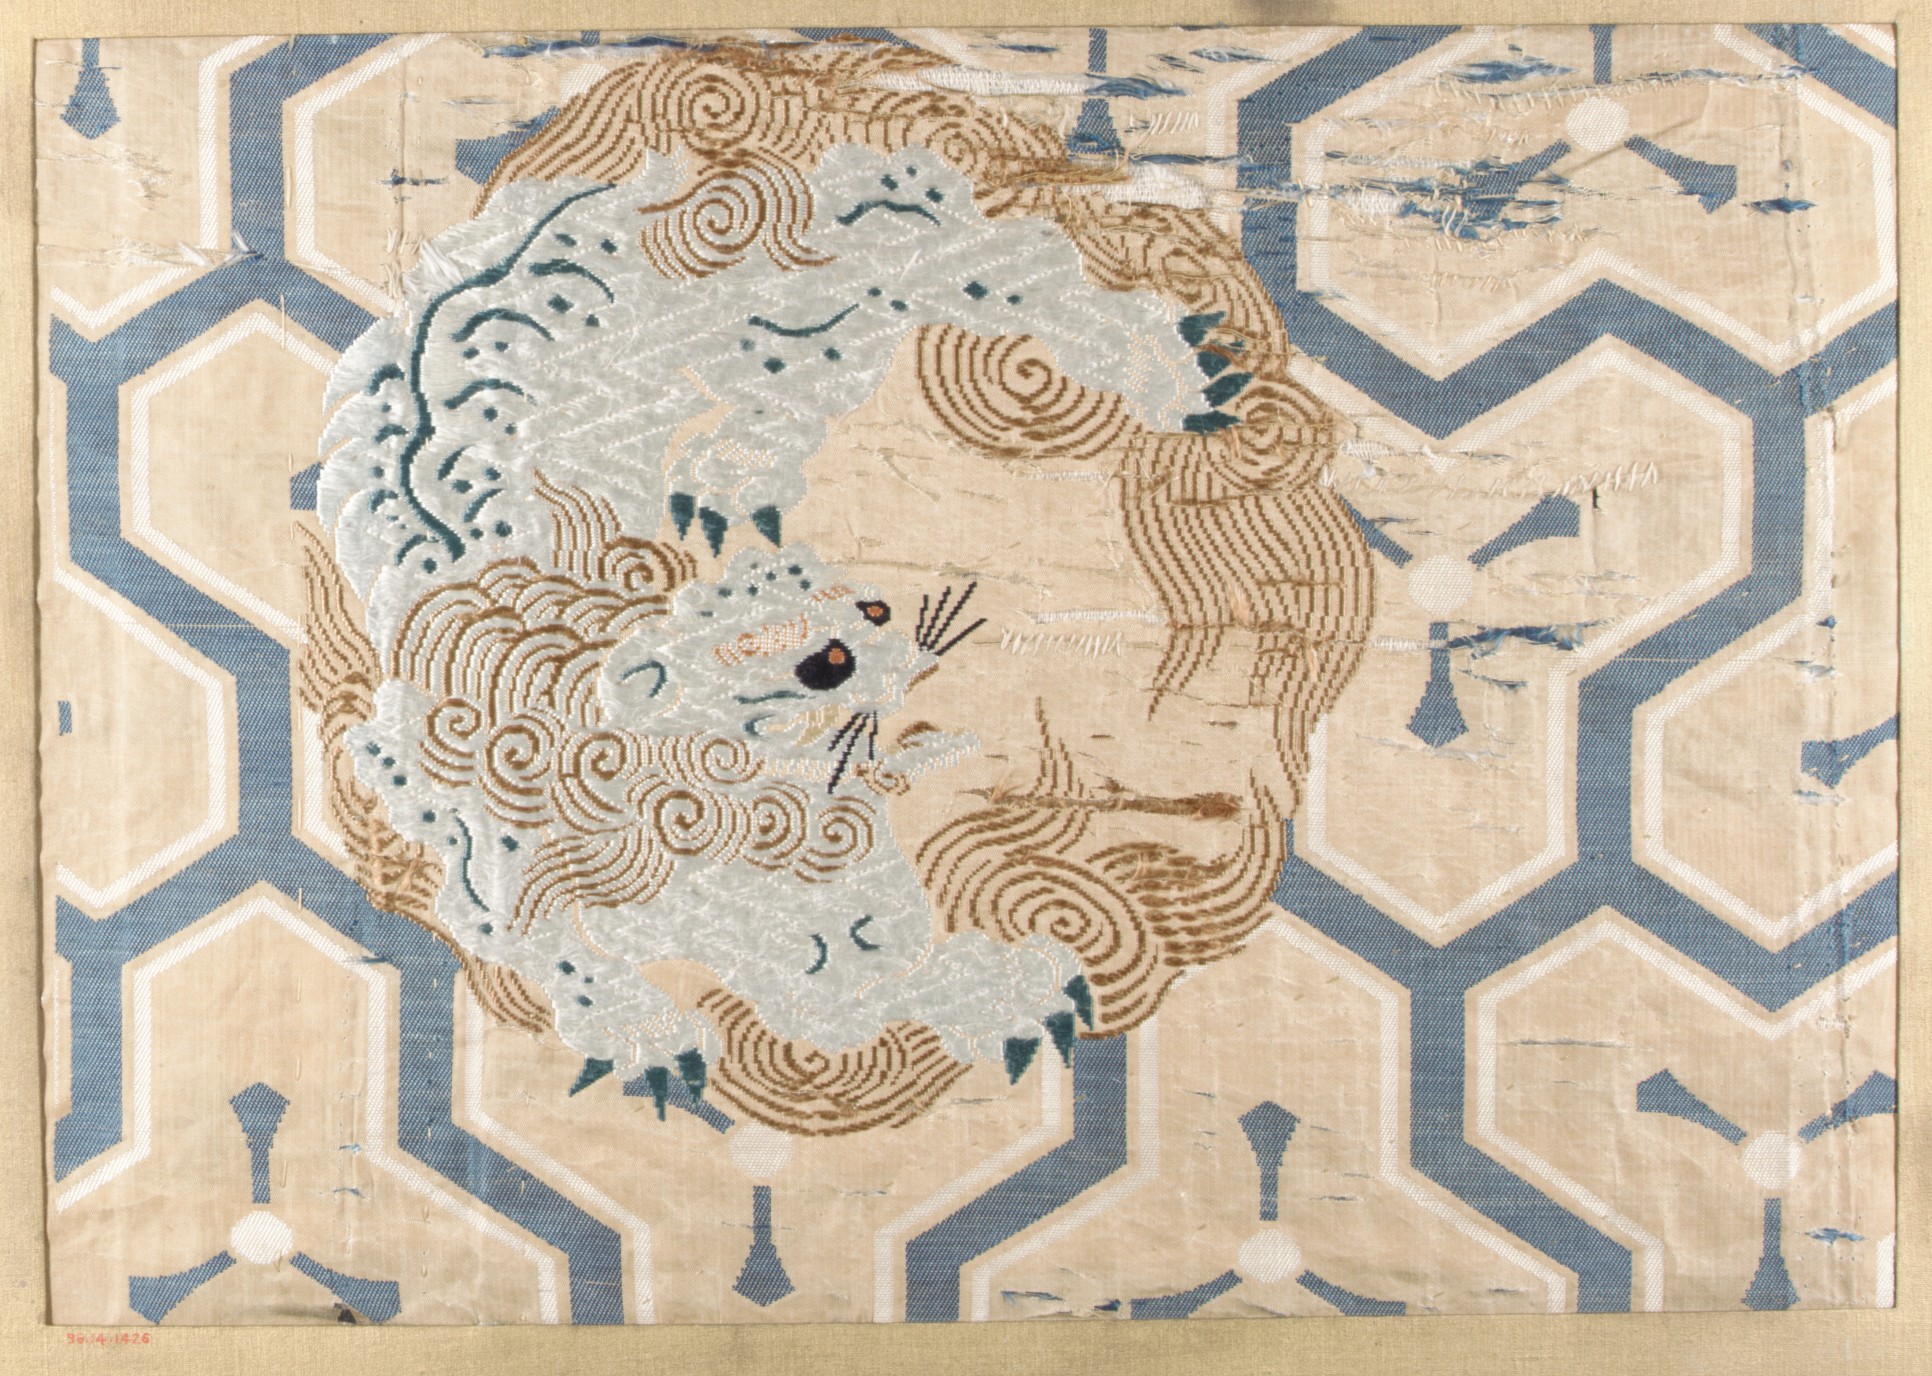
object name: piece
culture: japanese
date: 1701-1900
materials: silk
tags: lions